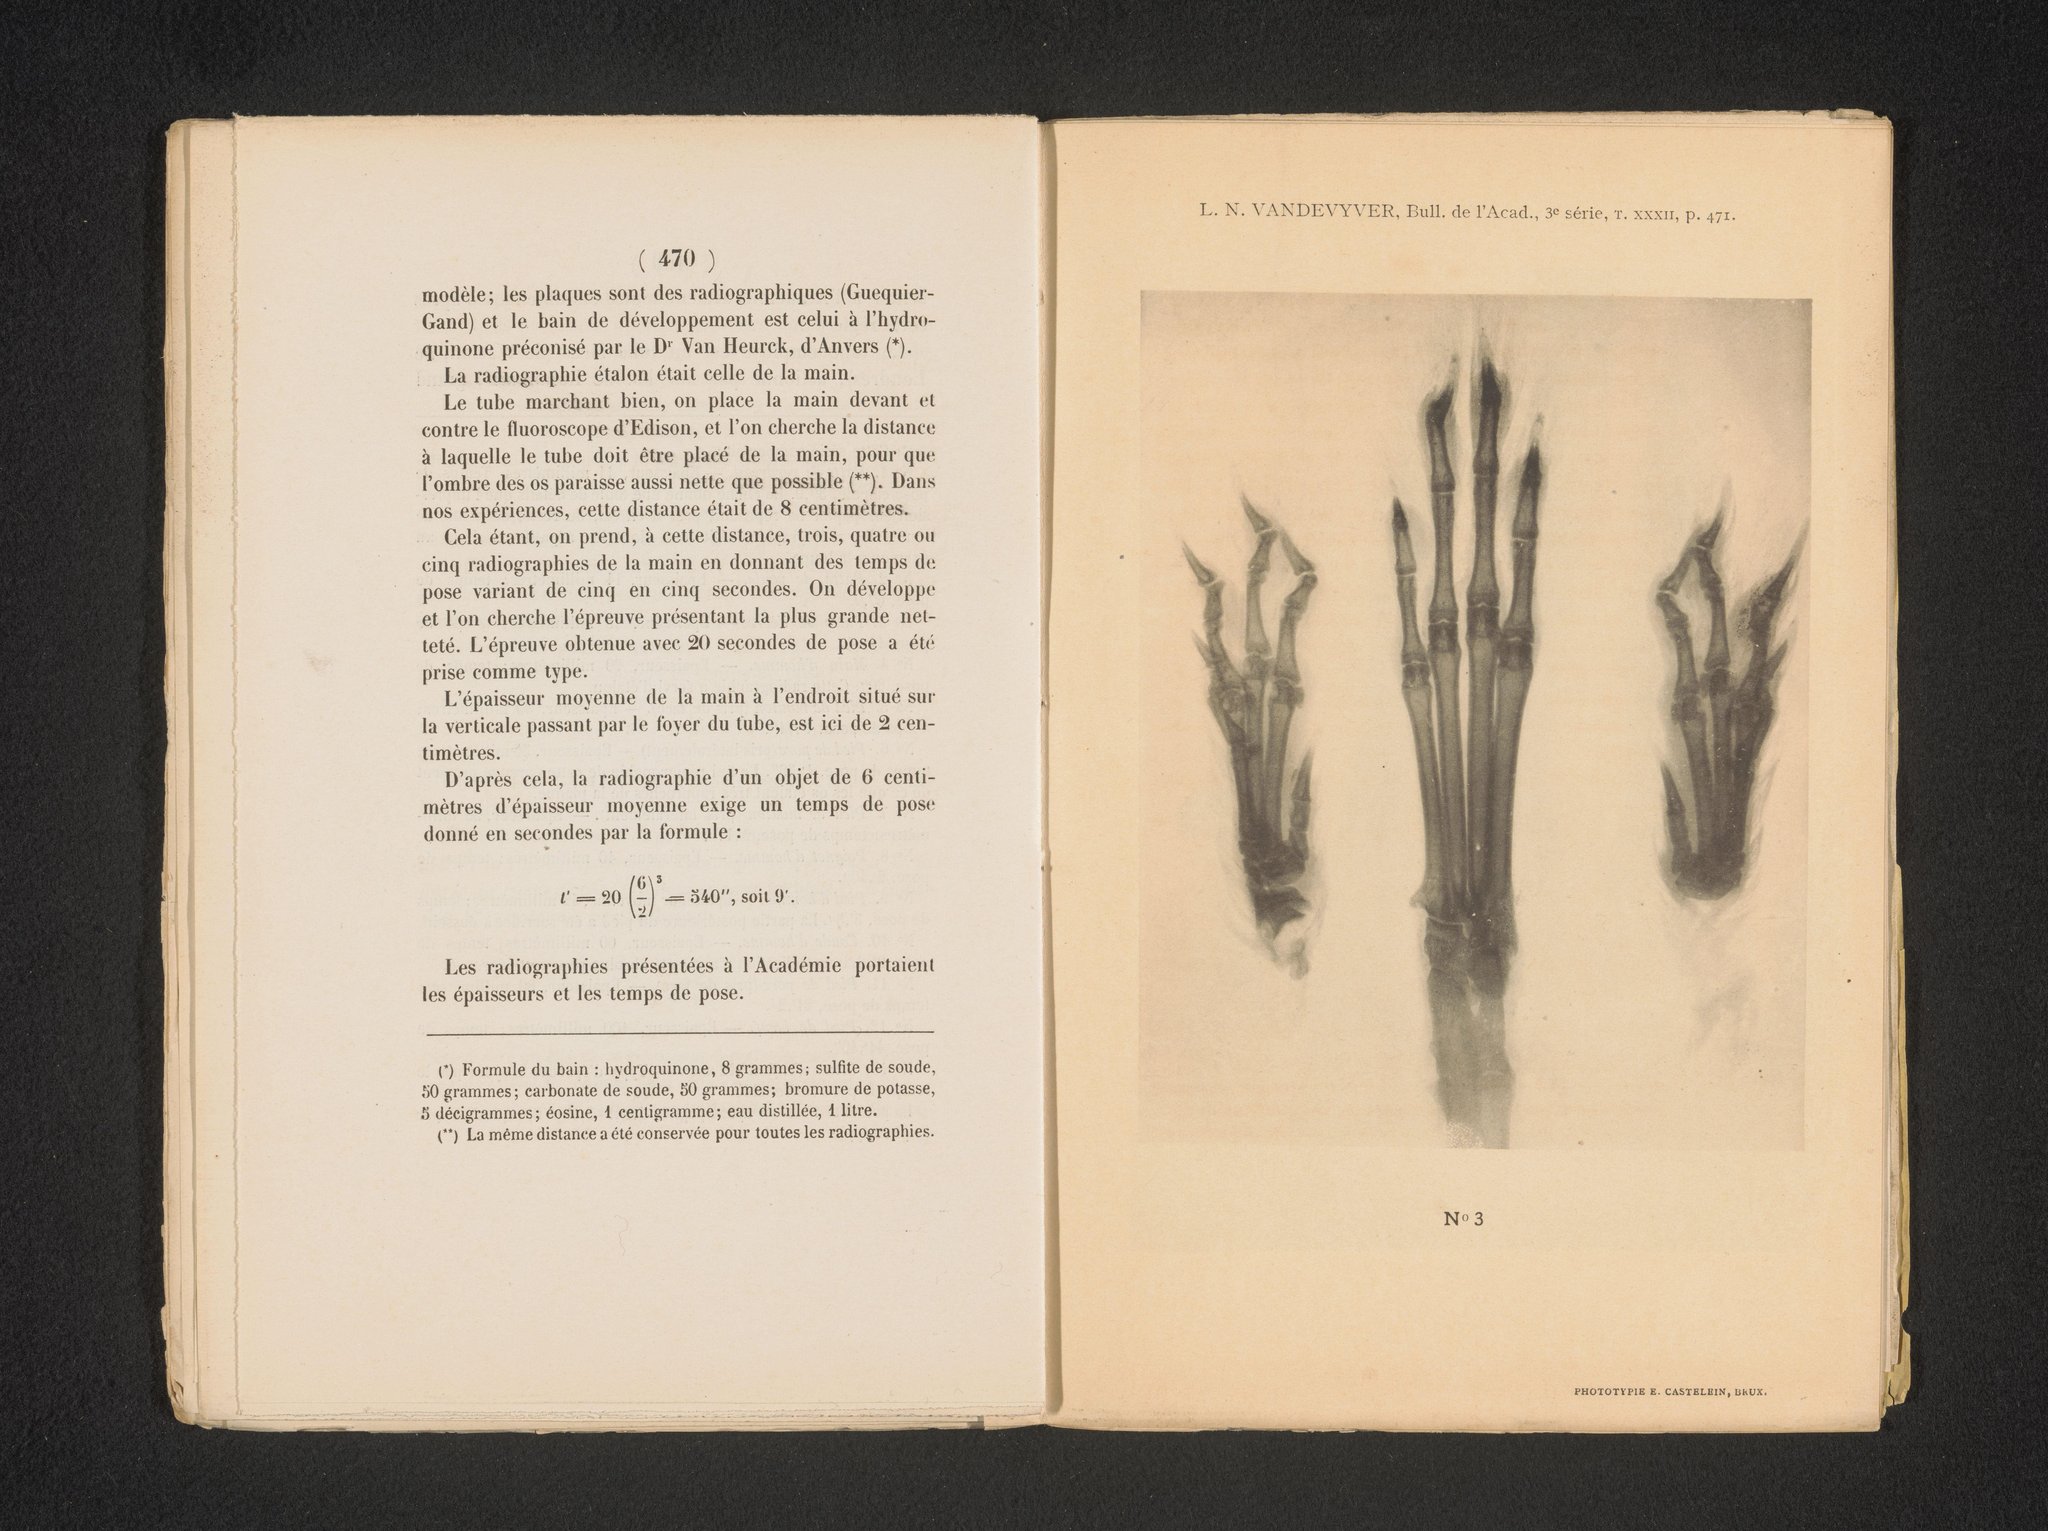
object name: photomechanical print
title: Röntgenfoto van drie hazenpoten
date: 1891-1896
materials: paper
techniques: photograph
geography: brussels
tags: x-ray examination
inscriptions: number: ‘No 3’